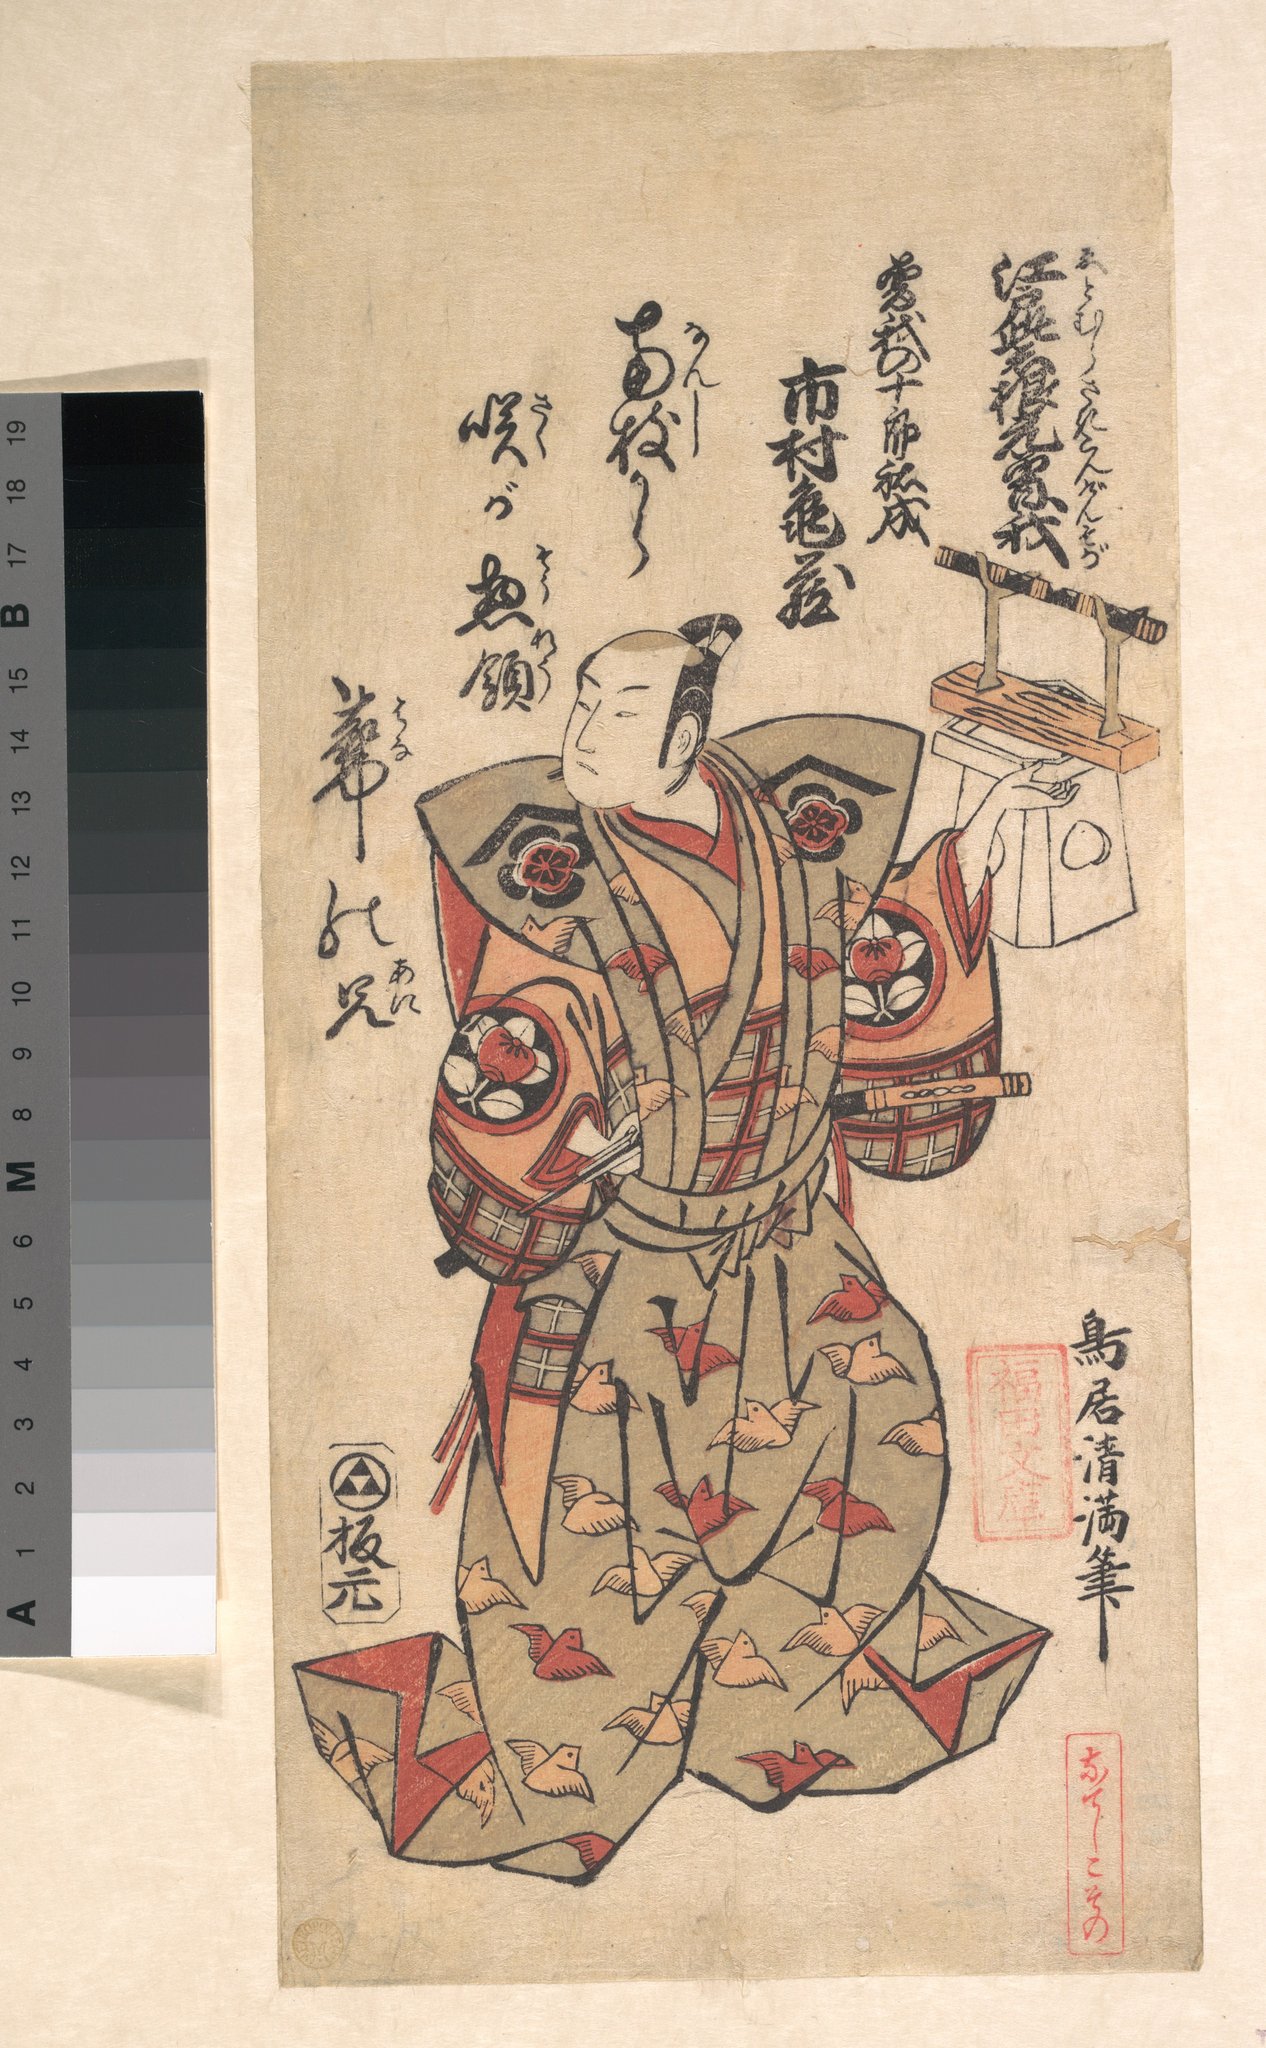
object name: woodblock print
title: The Actor Ichimura Kamezo in the Role of Sogo no Juro Sukenari, in the Drama "Edo Murasaki Kongen Soga"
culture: japanese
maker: torii kiyomitsu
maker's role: artist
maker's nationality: japanese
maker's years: 1735-1785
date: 1761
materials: ink, paper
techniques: woodblock print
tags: men,actors